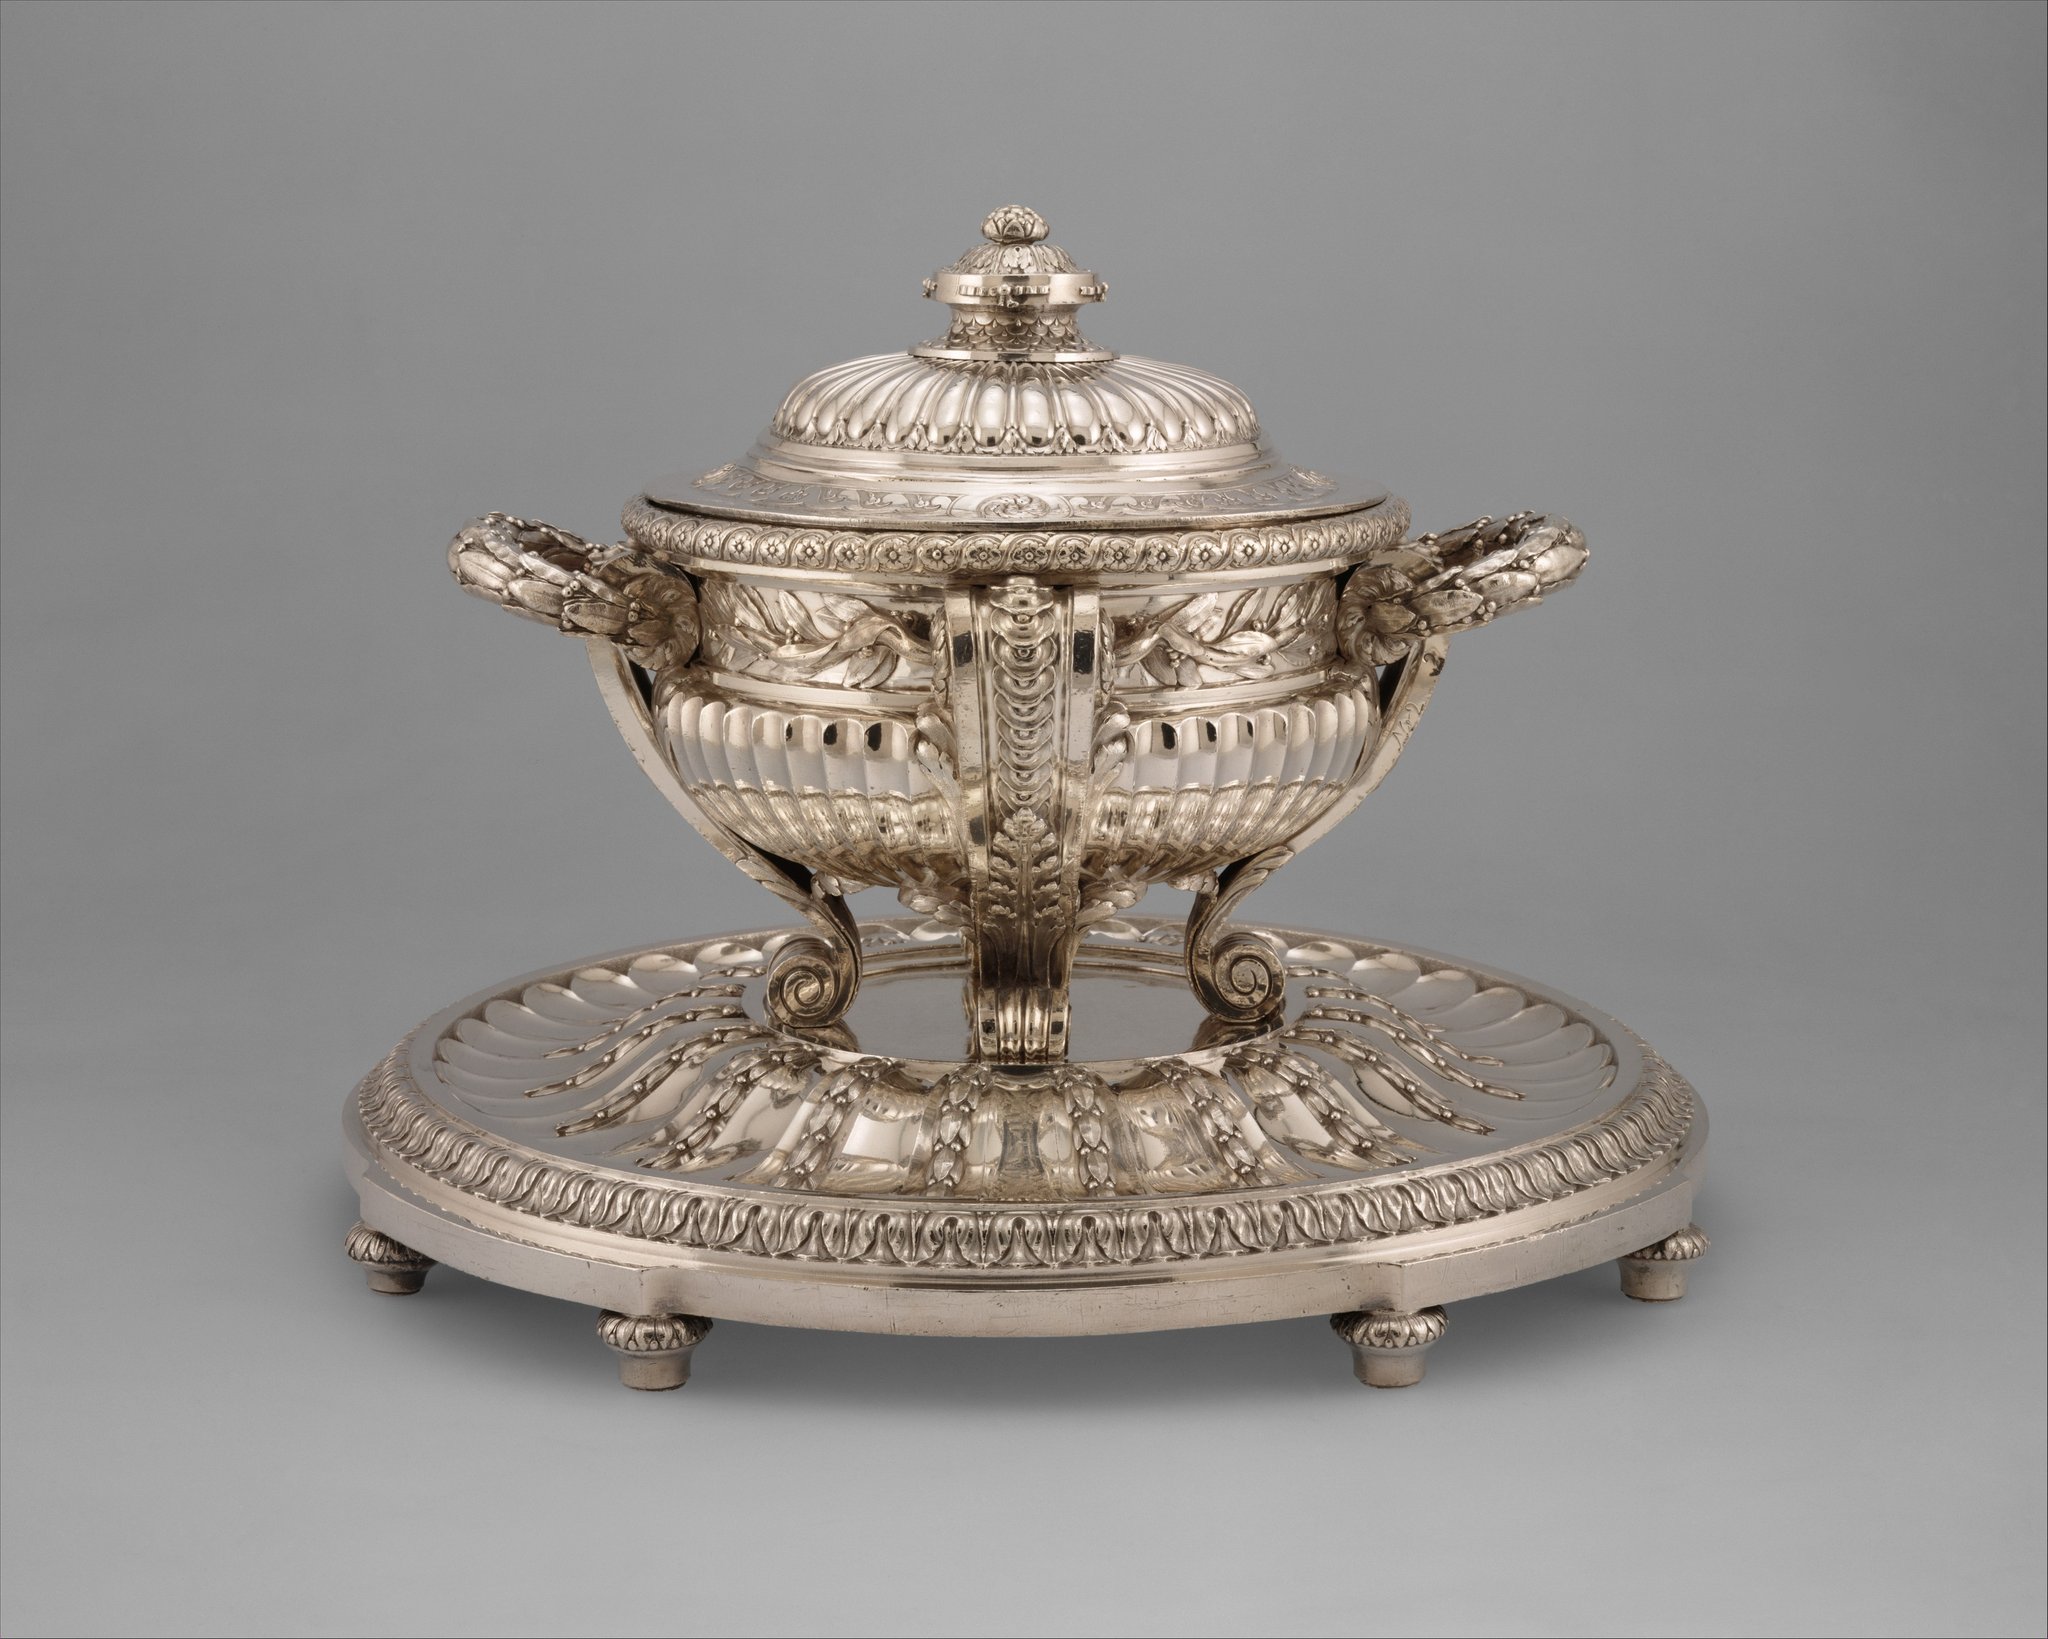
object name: tureen with cover and stand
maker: jacques-nicolas roettiers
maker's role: maker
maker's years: 1736-1788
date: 1770-1771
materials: silver